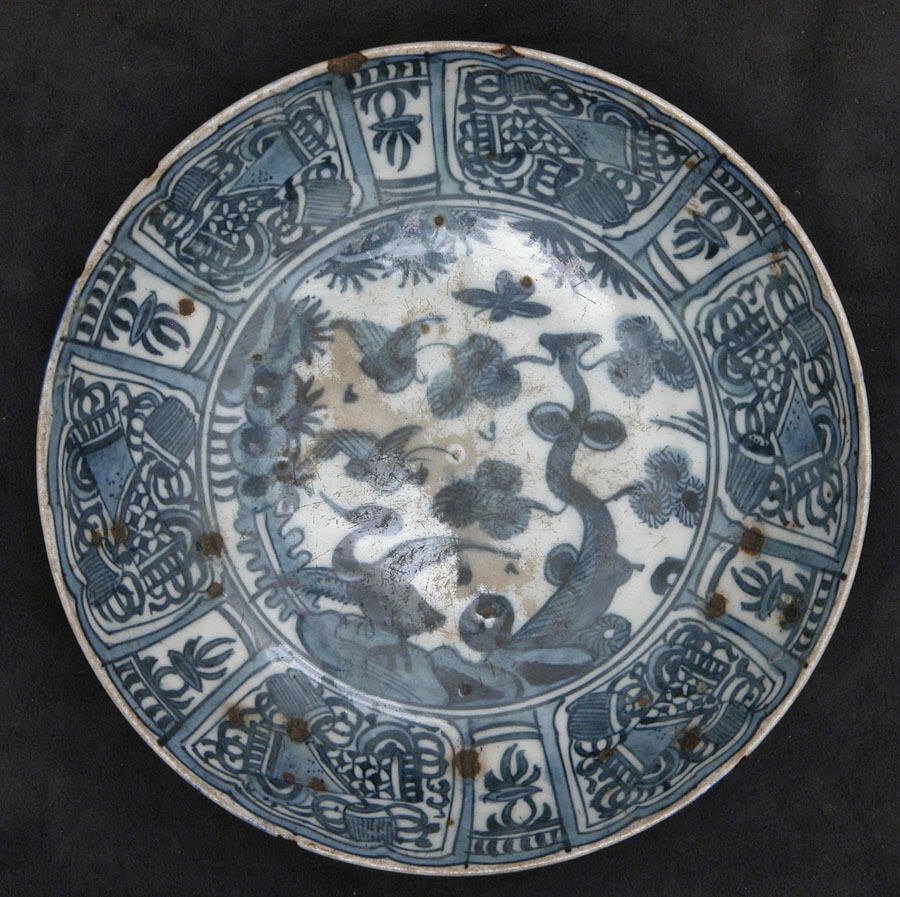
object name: bowl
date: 1701-1800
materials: stonepaste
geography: iran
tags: birds